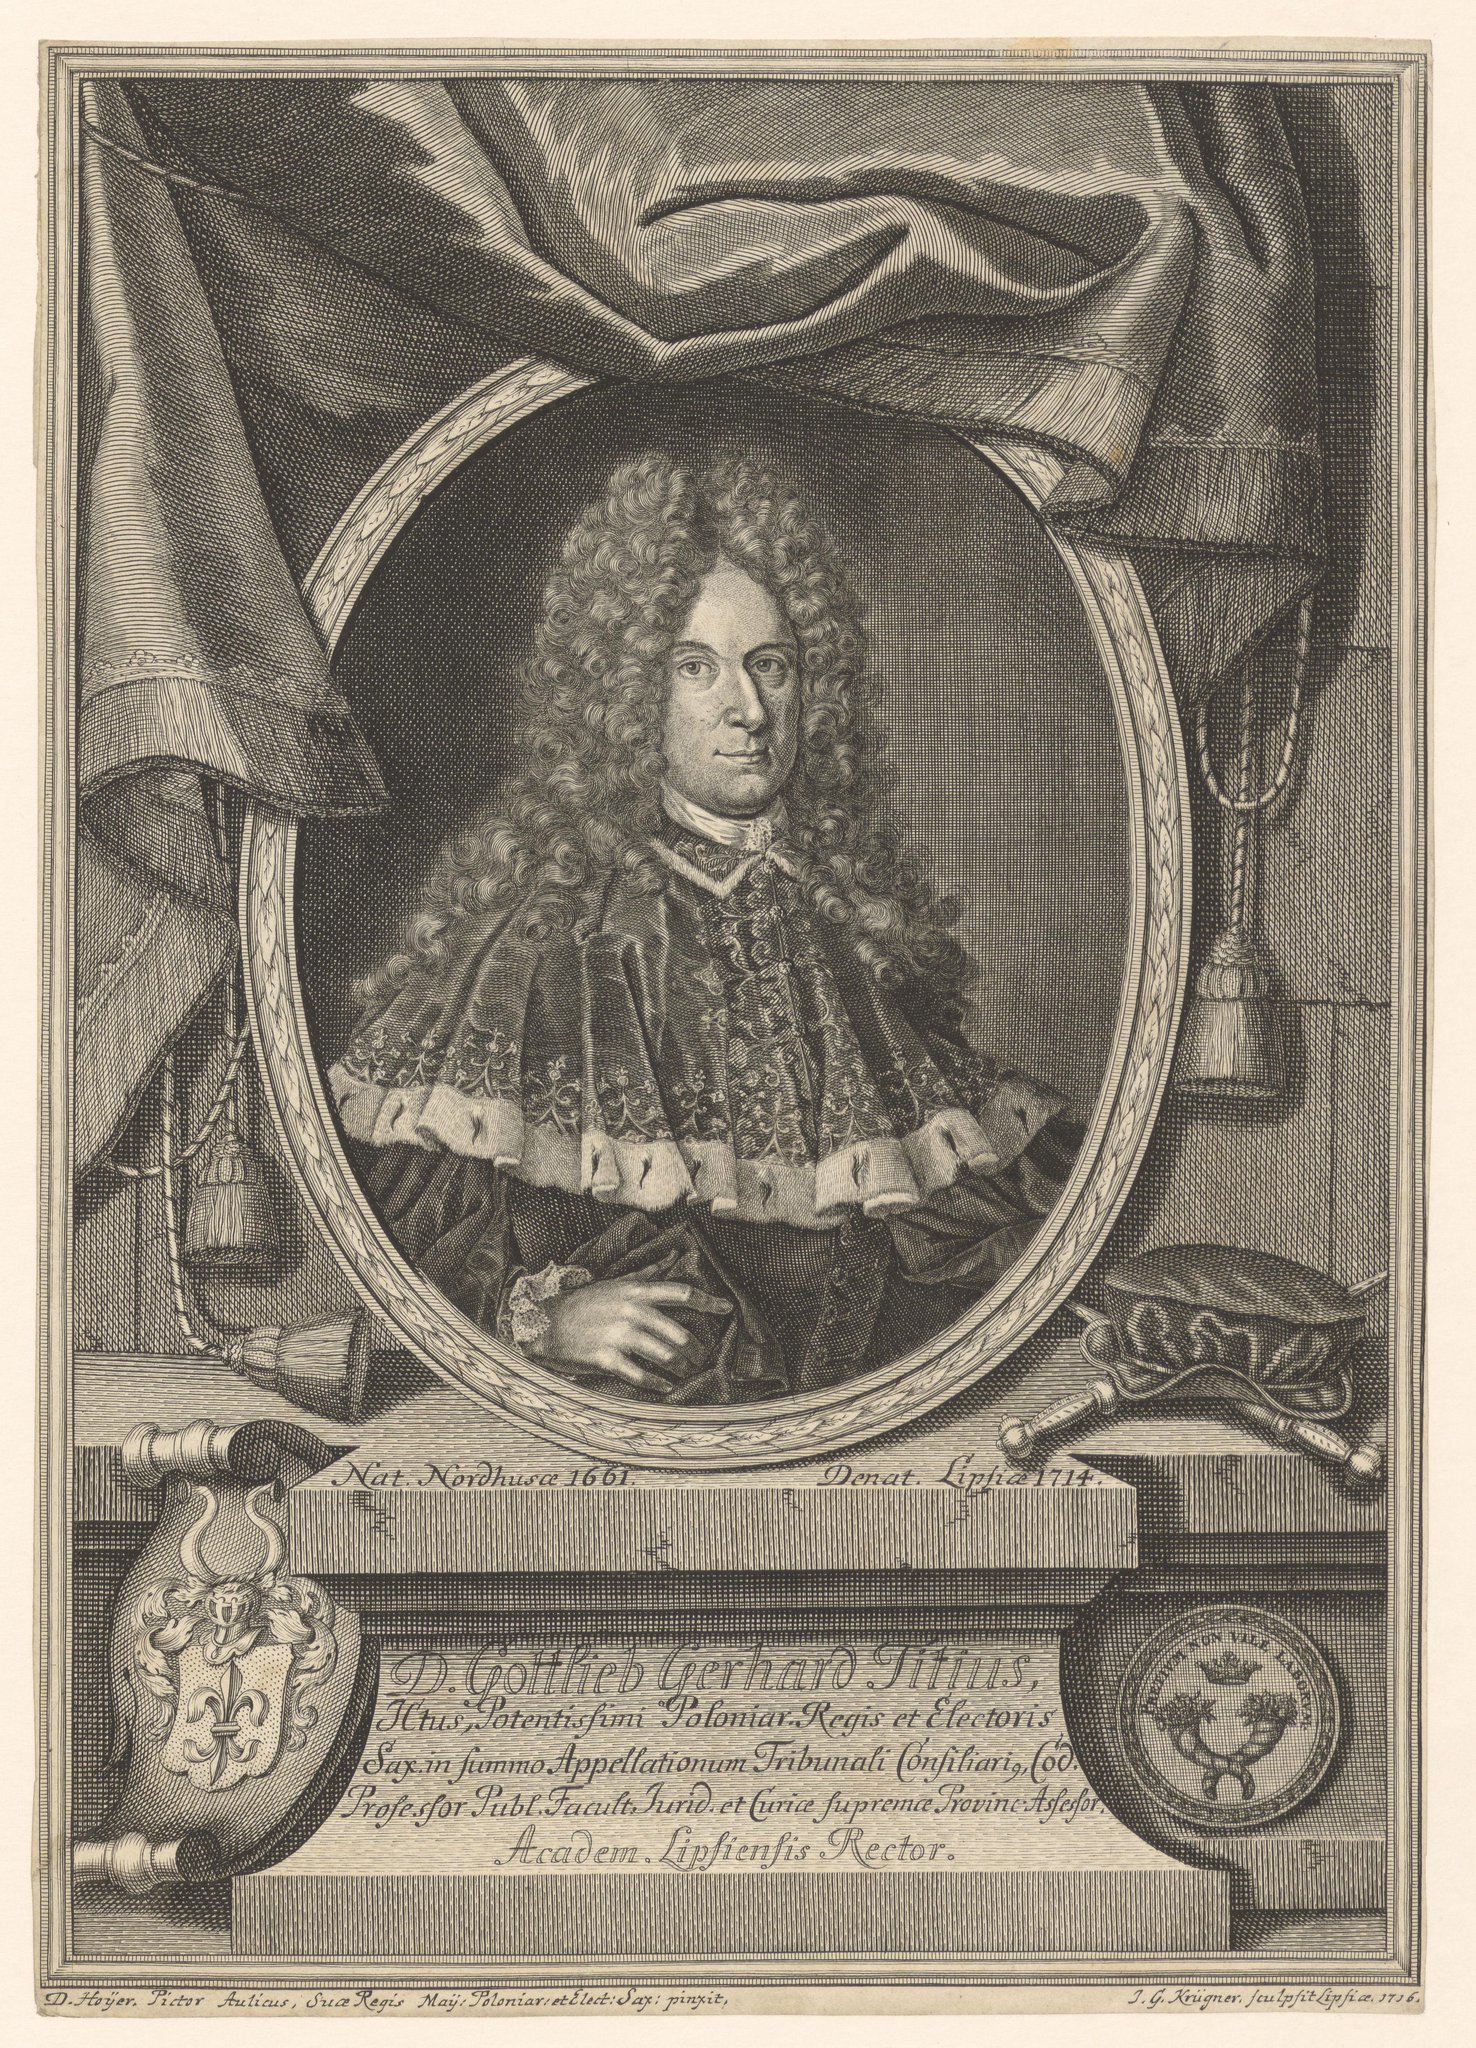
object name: print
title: Portret van Gottlieb Gerhard Titius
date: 1716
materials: paper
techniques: engraving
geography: leipzig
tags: further education (+ portrait of teacher, professor), historical persons, lawyer, attorney at law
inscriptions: collector's mark: Lugt 2228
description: Tekst in het Latijn op en bij de sokkel.